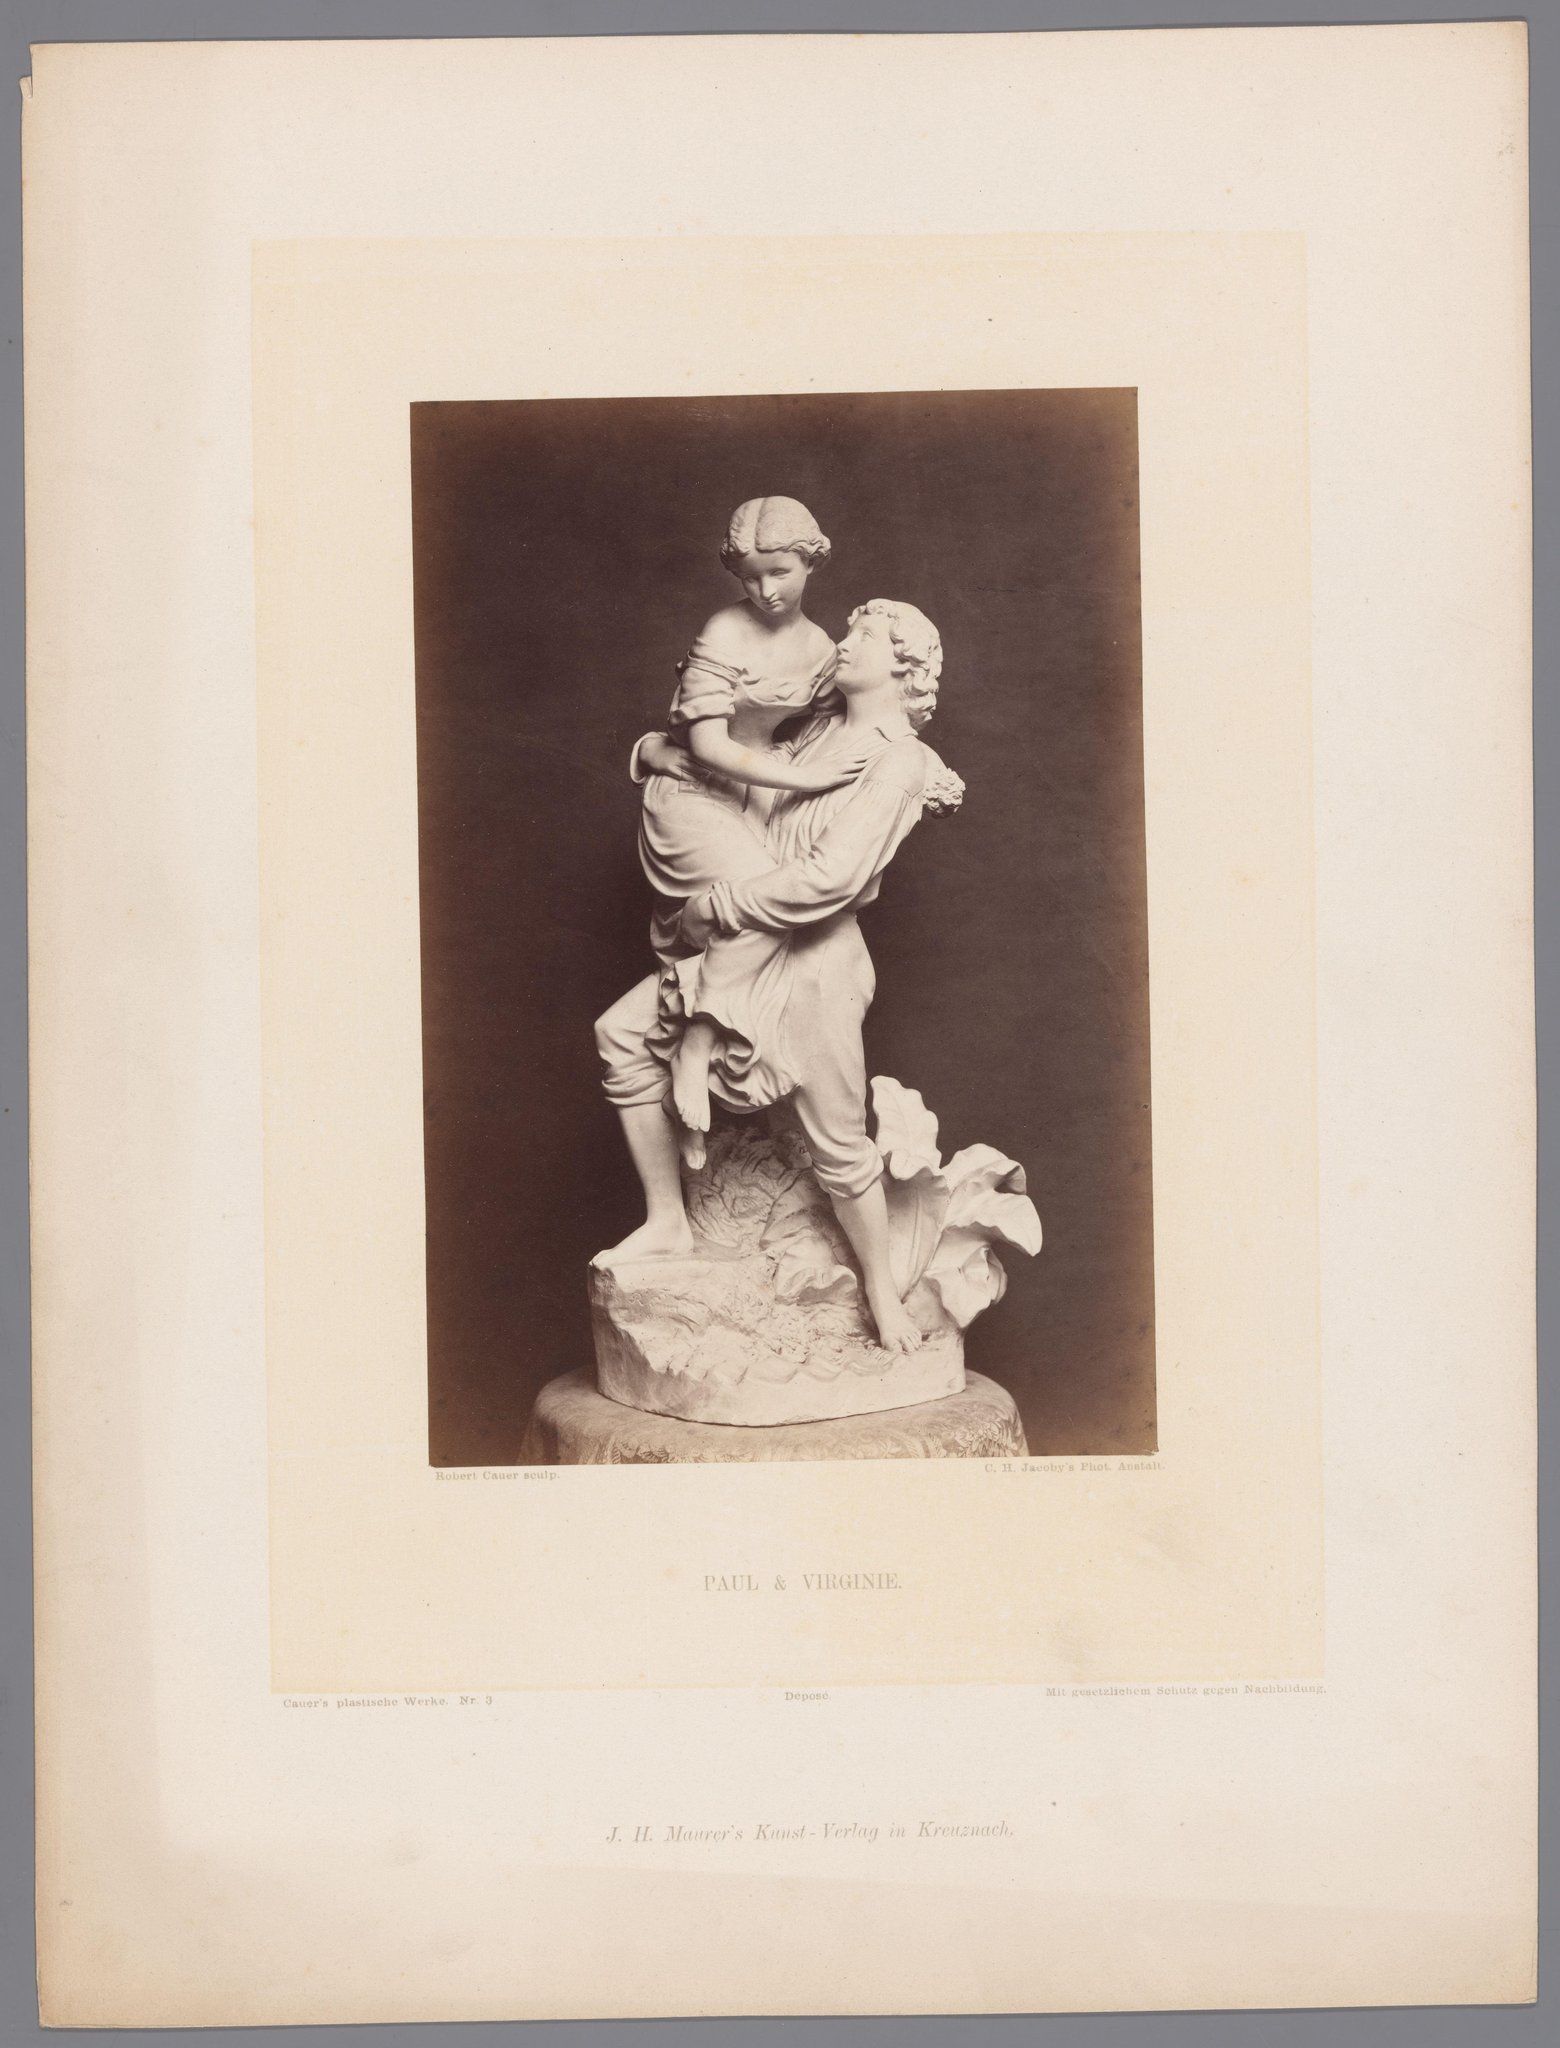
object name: photograph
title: Paul en Virginie door Robert Cauer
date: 1850-1900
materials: cardboard, photographic support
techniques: albumen print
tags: (scenes from) specific works of literature: bernardin de saint-pierre, paul et virginie, sculpture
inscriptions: inscription: ‘Robert Cauer sculp./Cauer's plastische Werke. Nr. 3 Déposé. Mit gesetzlichem Schutz gegen Nachbildung’